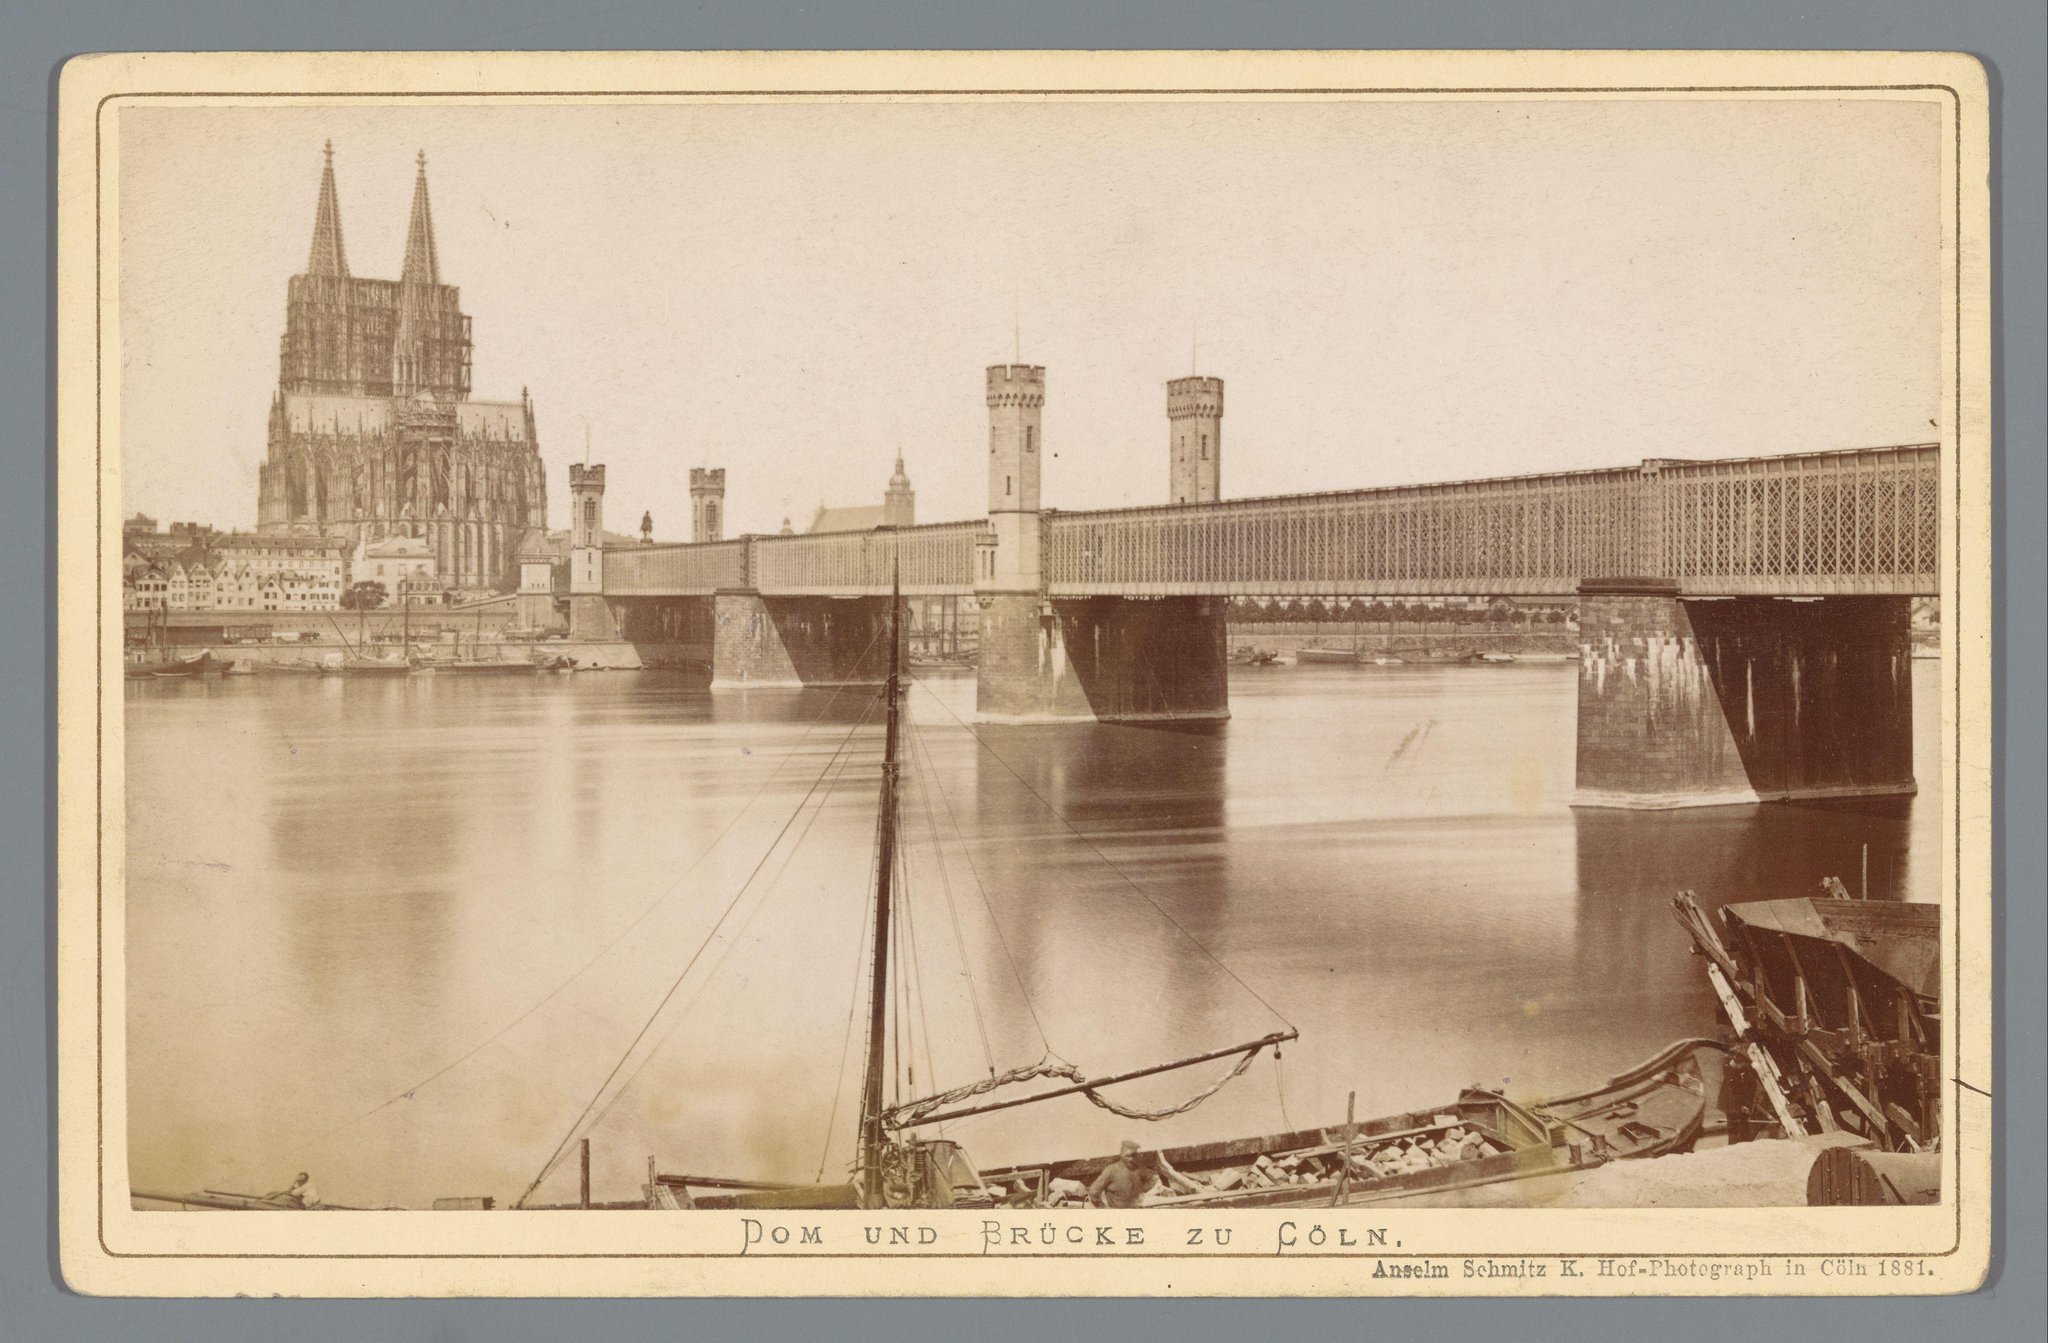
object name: cabinet photograph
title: De Dom en brug in Keulen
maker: anselm schmitz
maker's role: publisher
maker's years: 1831-1903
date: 1881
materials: cardboard, photographic support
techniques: albumen print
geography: cologne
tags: city-view, and landscape with man-made constructions, bridge, dome ~ architecture, cologne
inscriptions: date